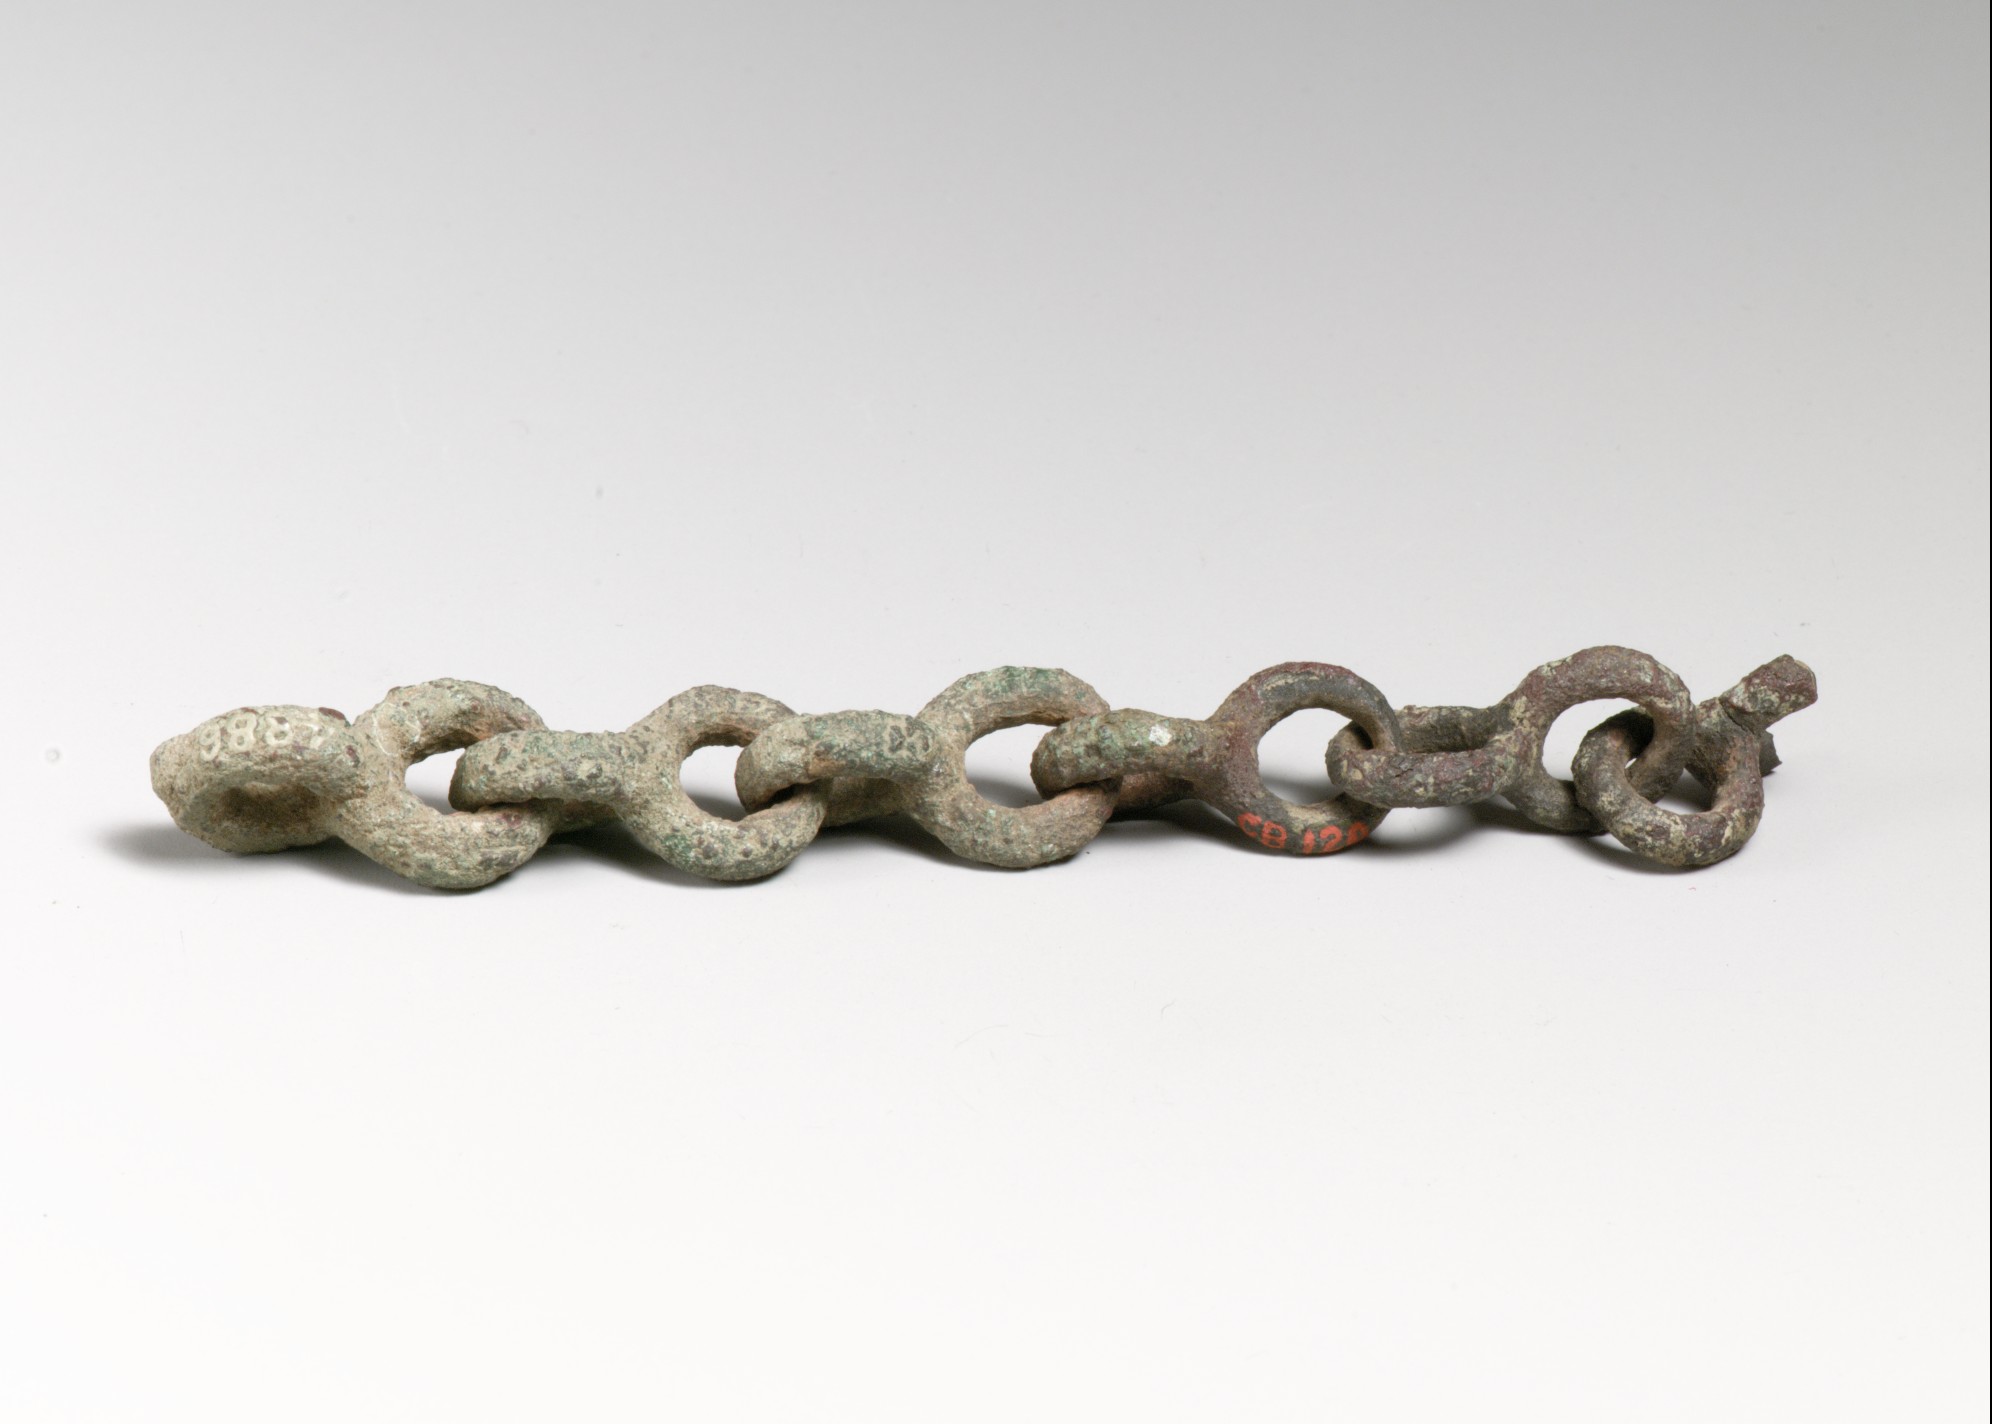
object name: chain, fragmentary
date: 7000 BCE-330 CE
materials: bronze